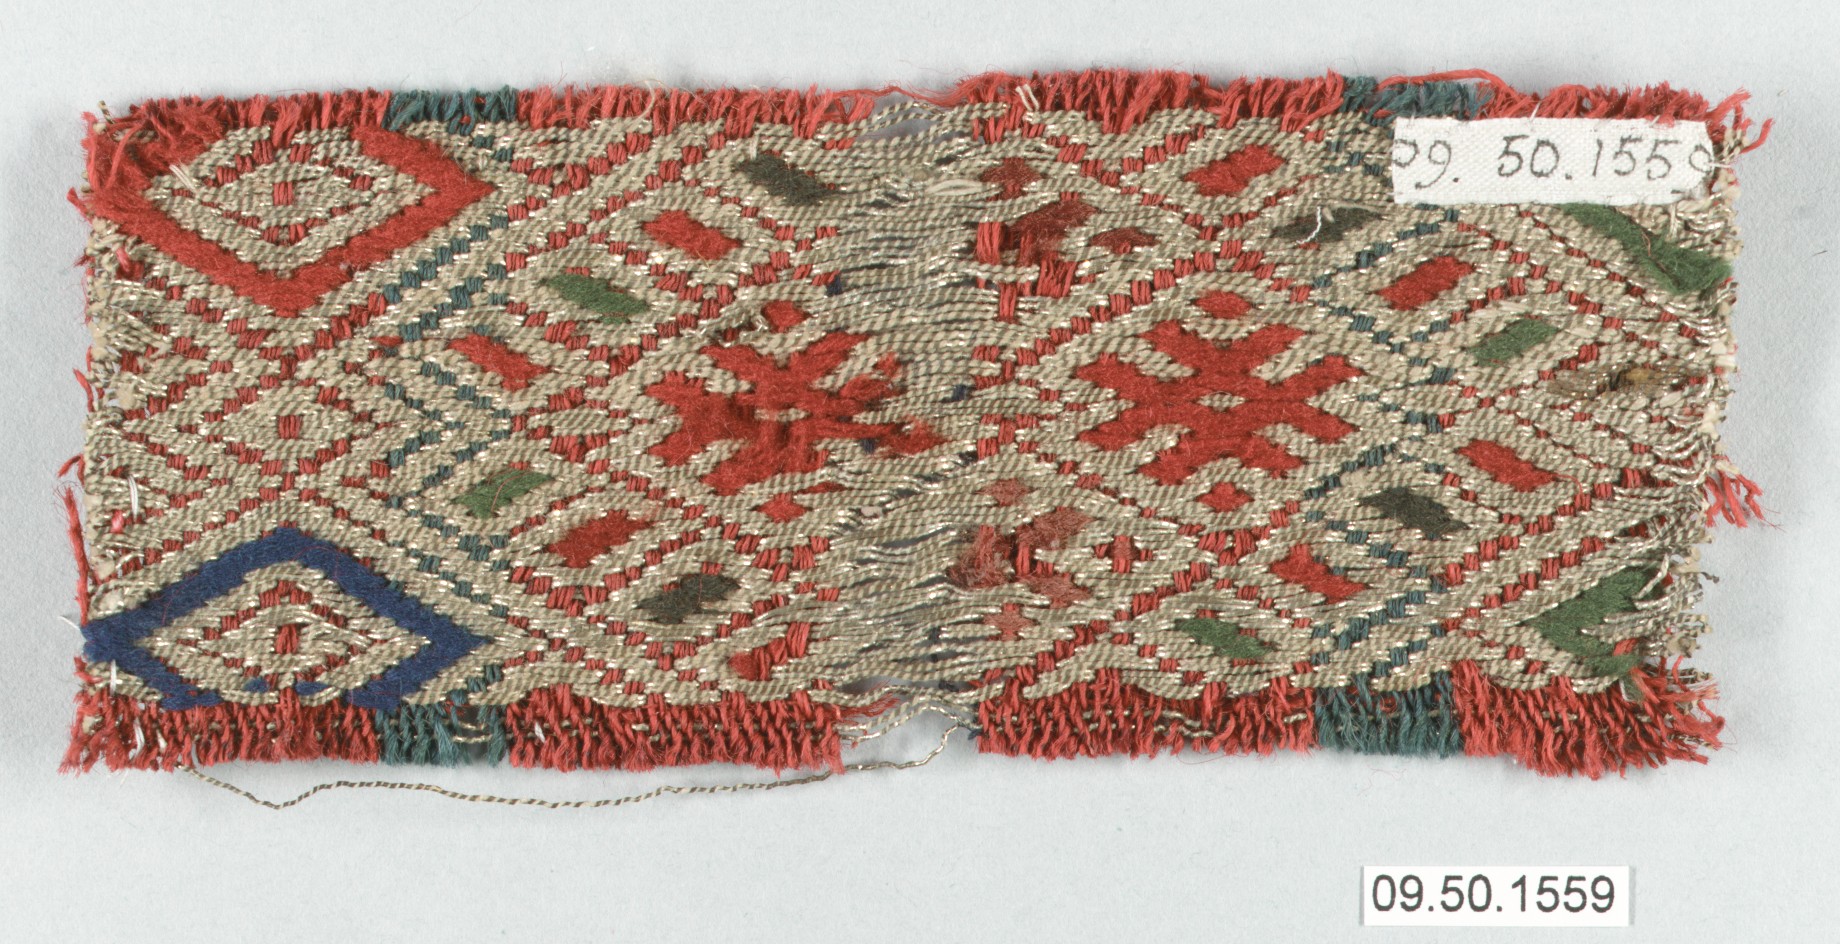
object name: fragment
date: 1801-1900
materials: metal thread